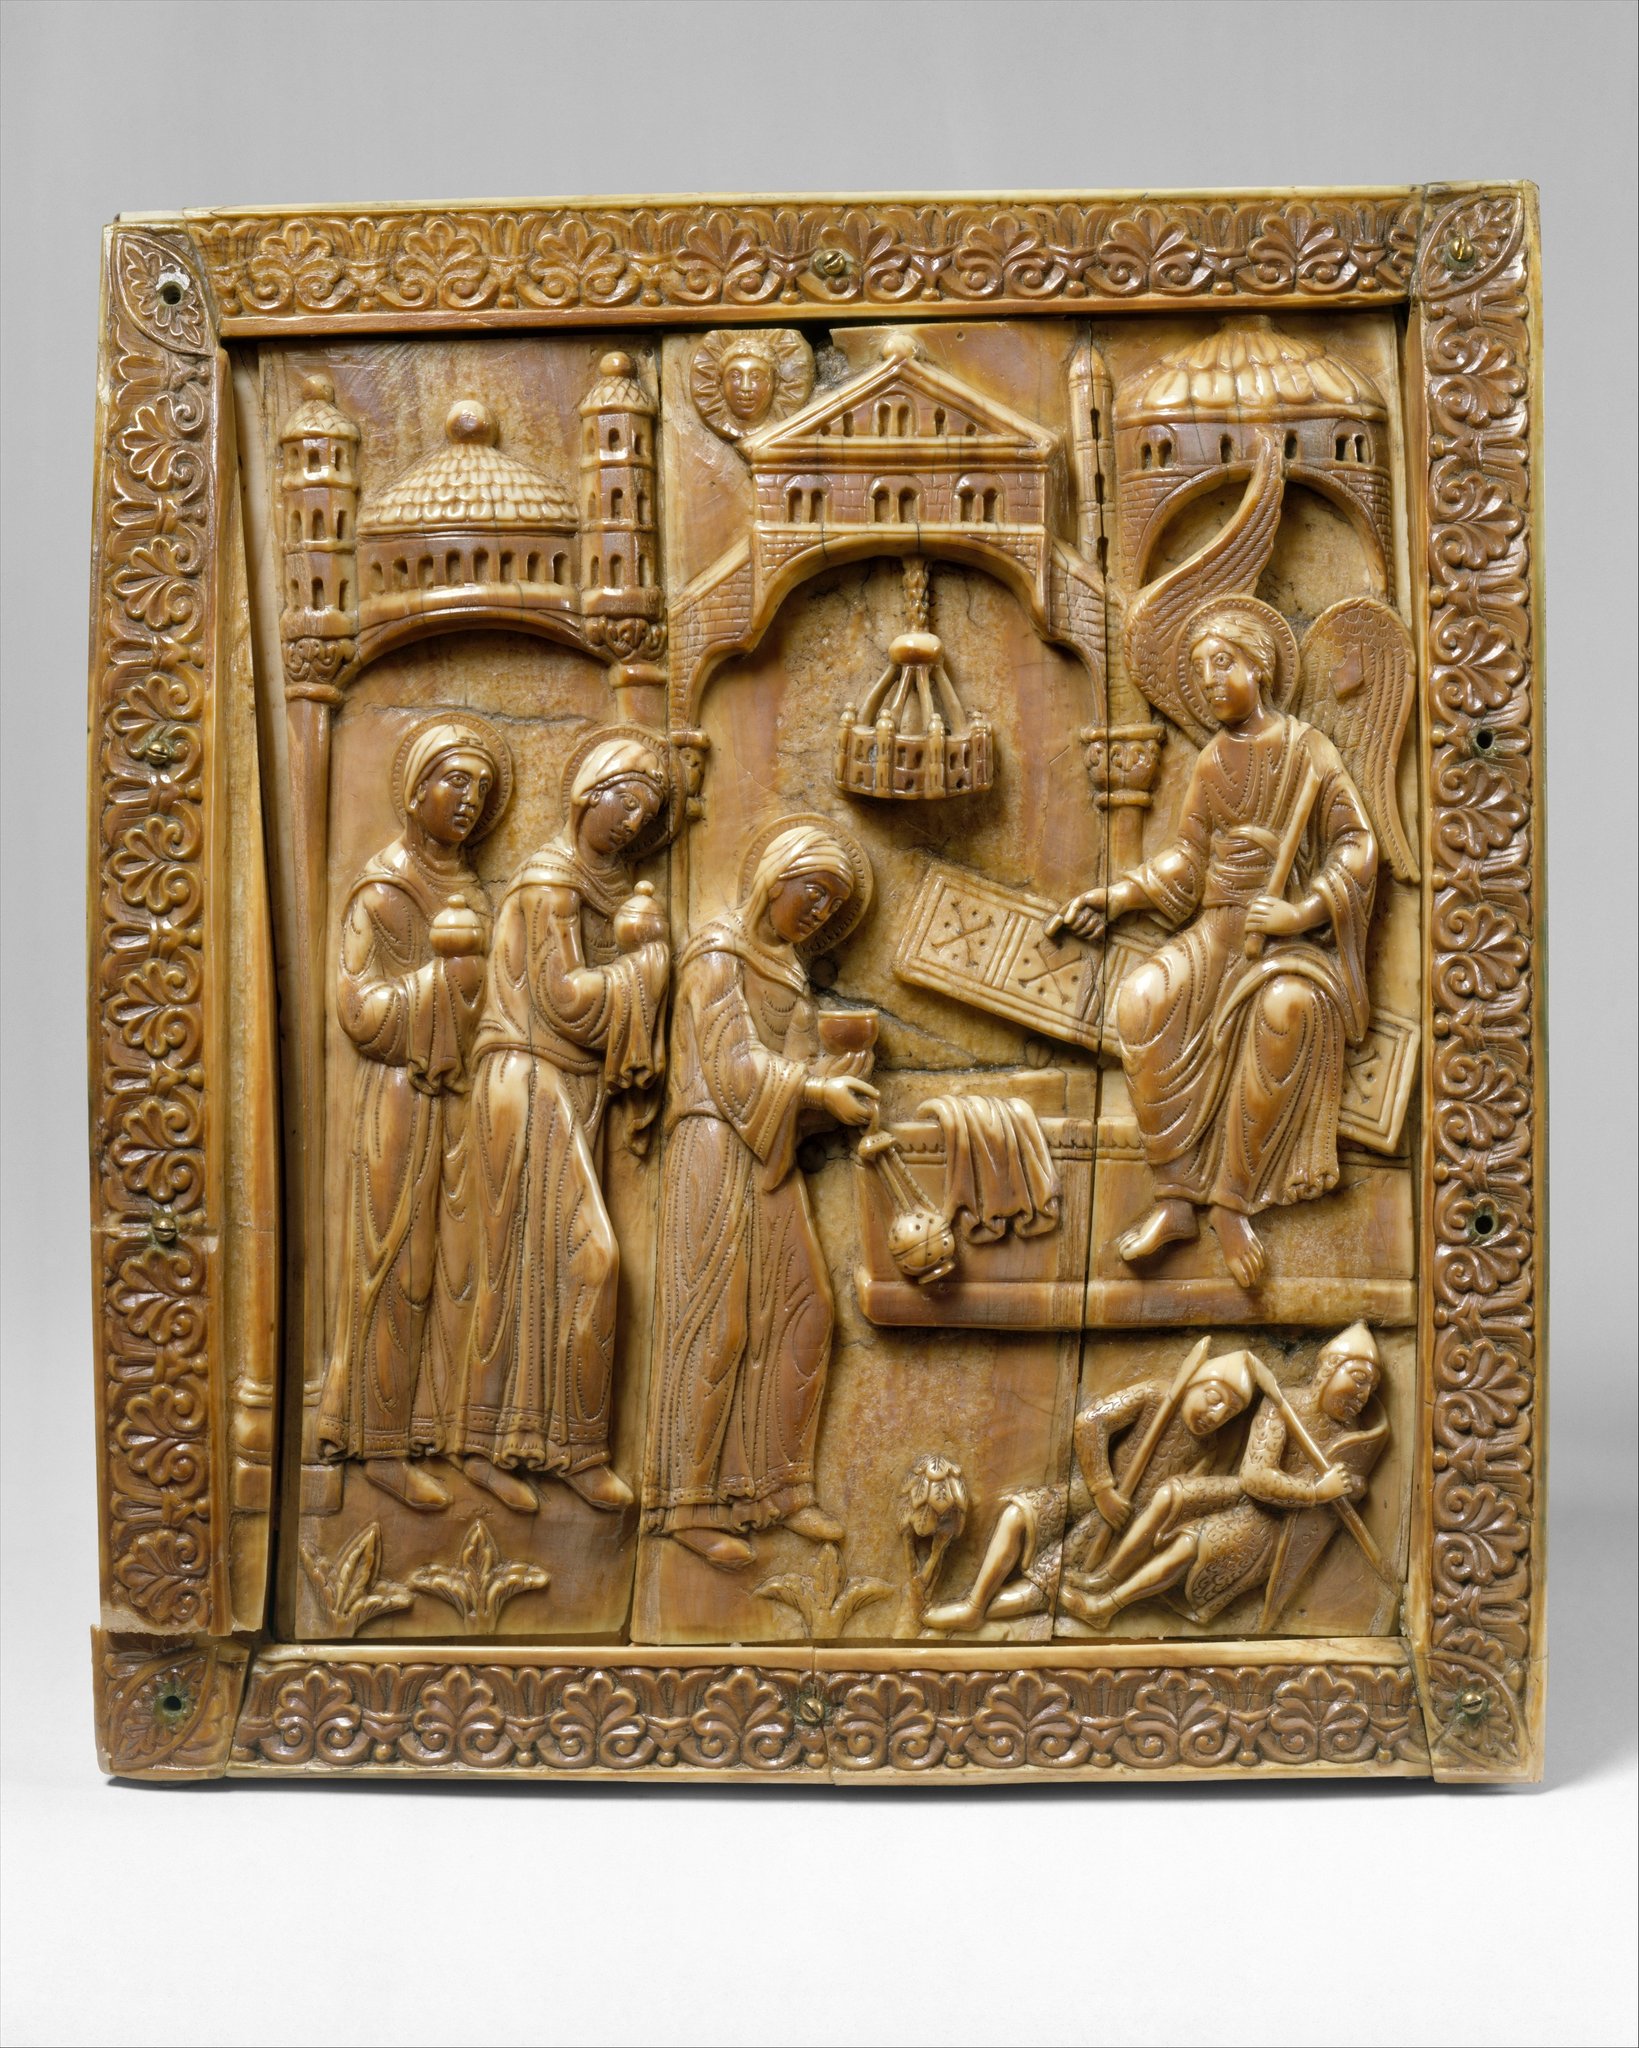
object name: plaque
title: Plaque with the Holy Women at the Sepulchre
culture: german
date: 1140-1160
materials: ivory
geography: germany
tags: men,women